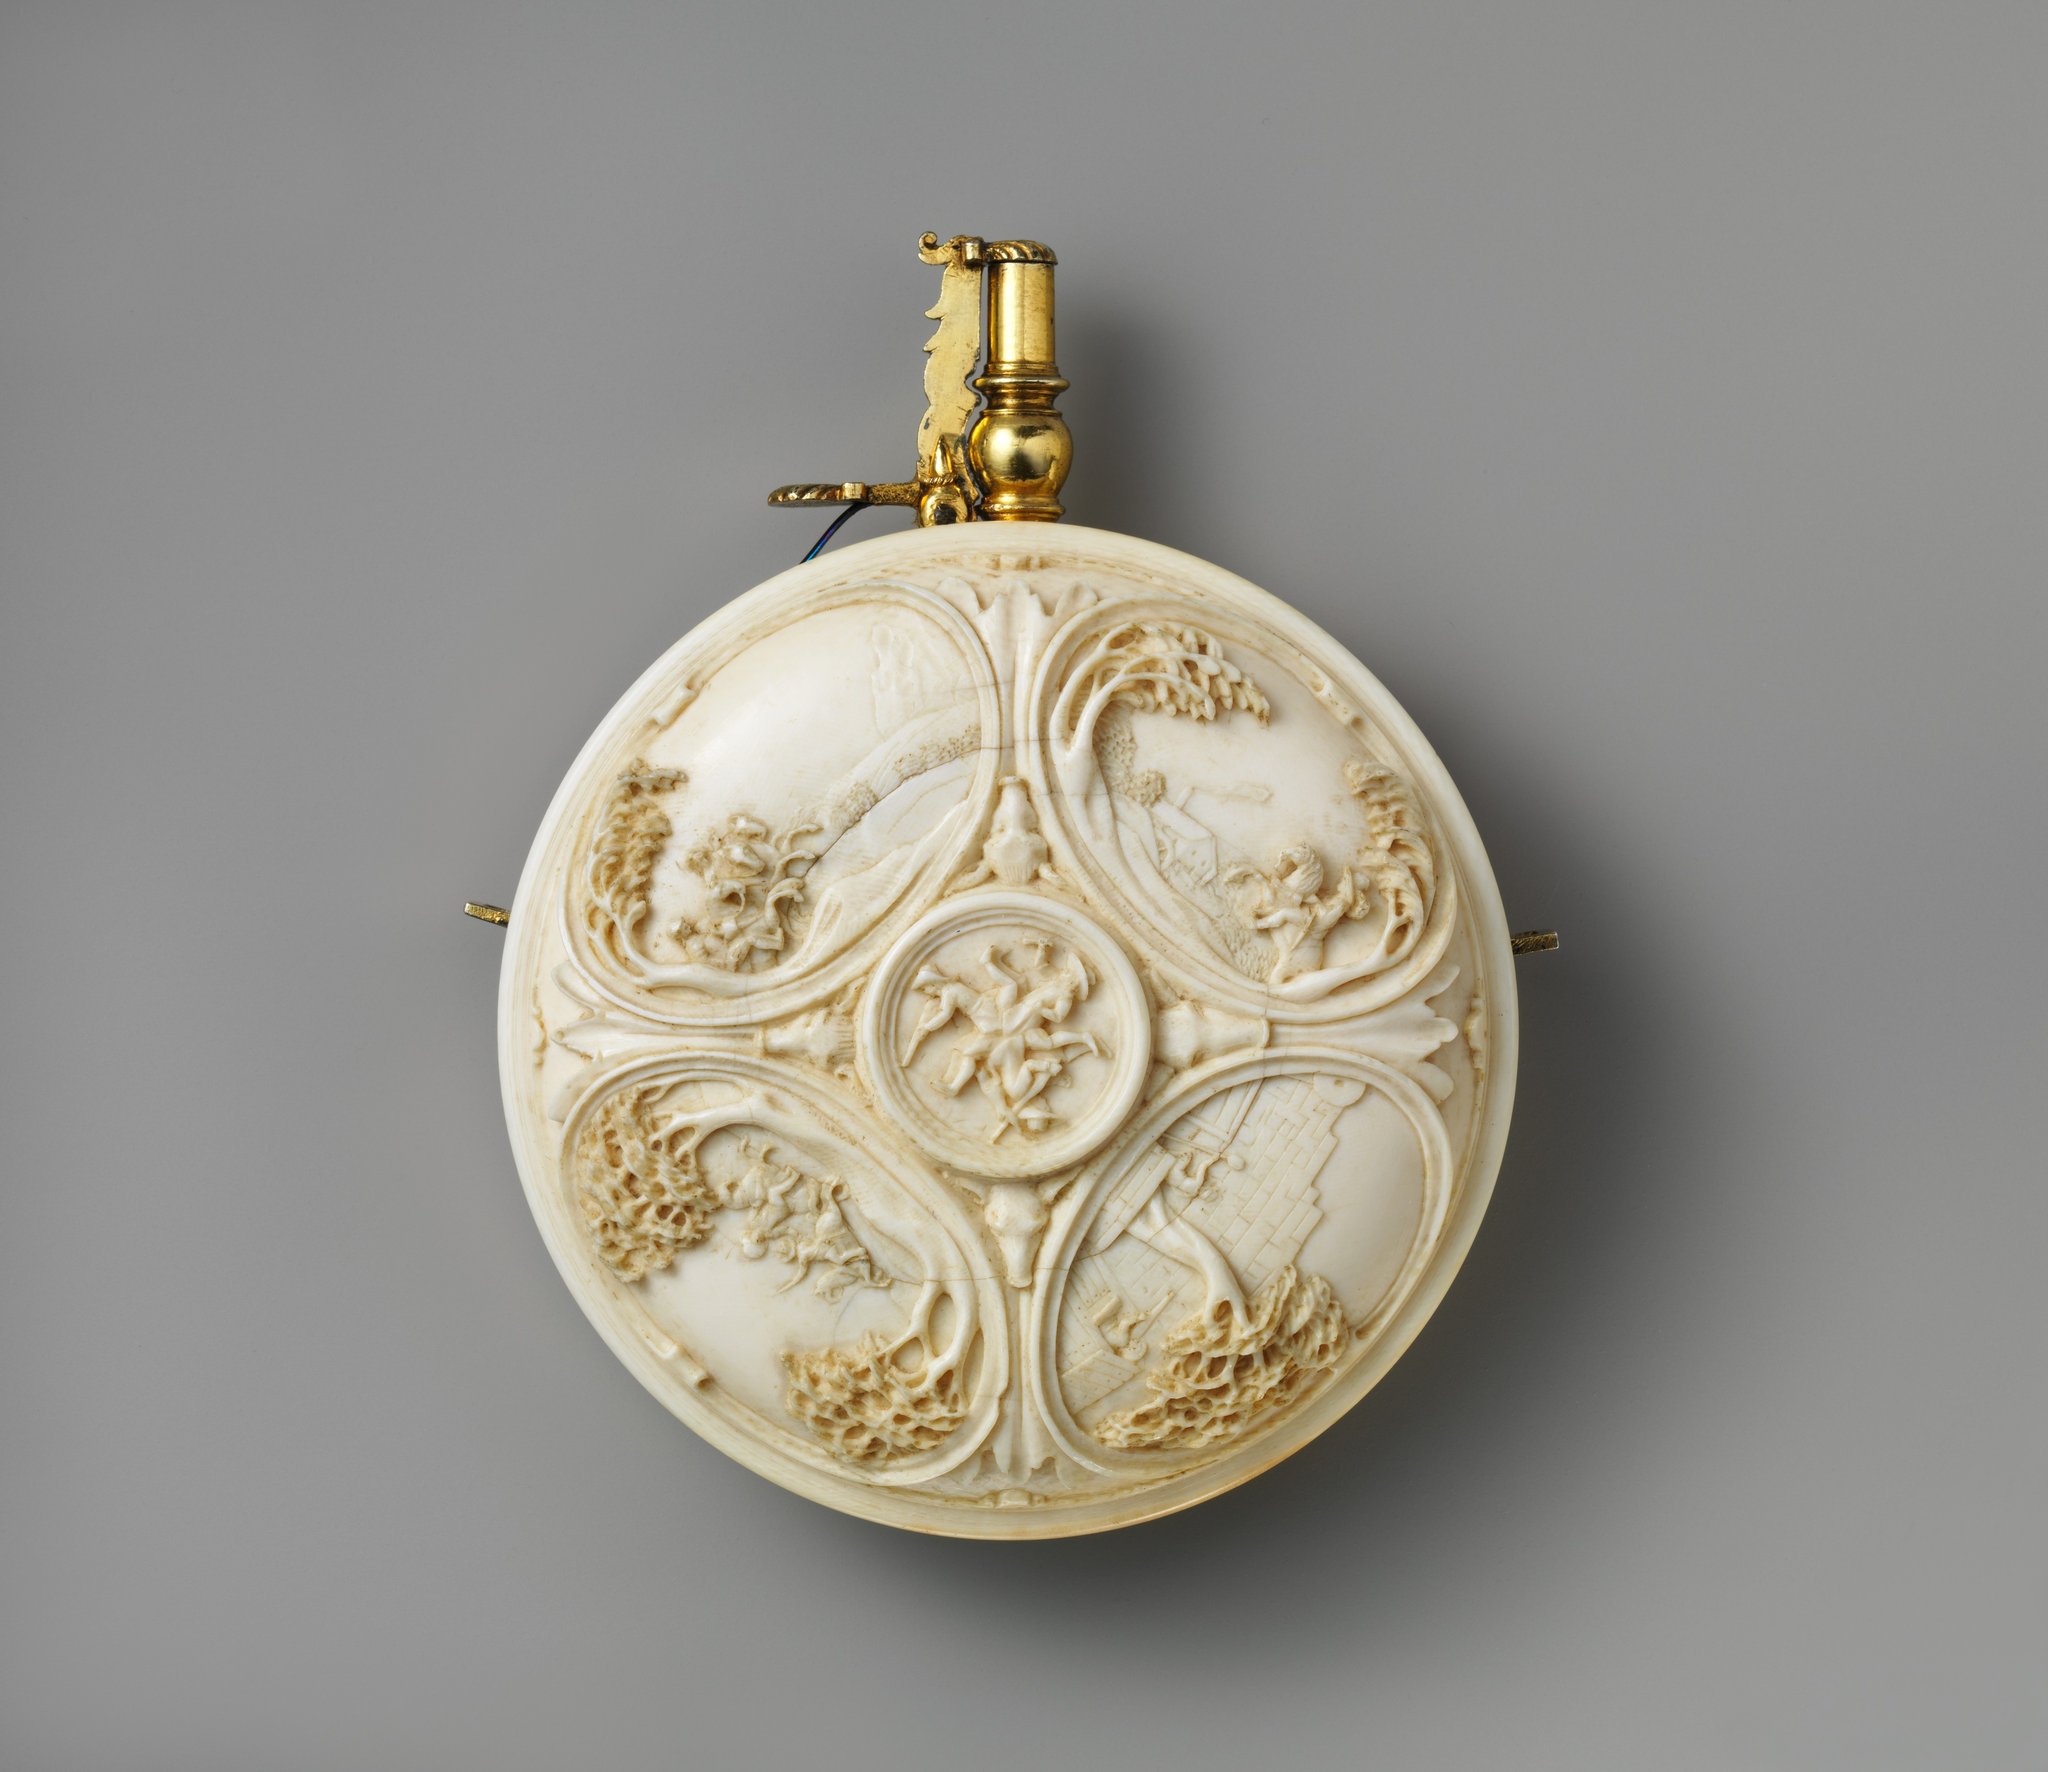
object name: powder flask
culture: german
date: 1667-1700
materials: gold, ivory, silver, steel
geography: germany